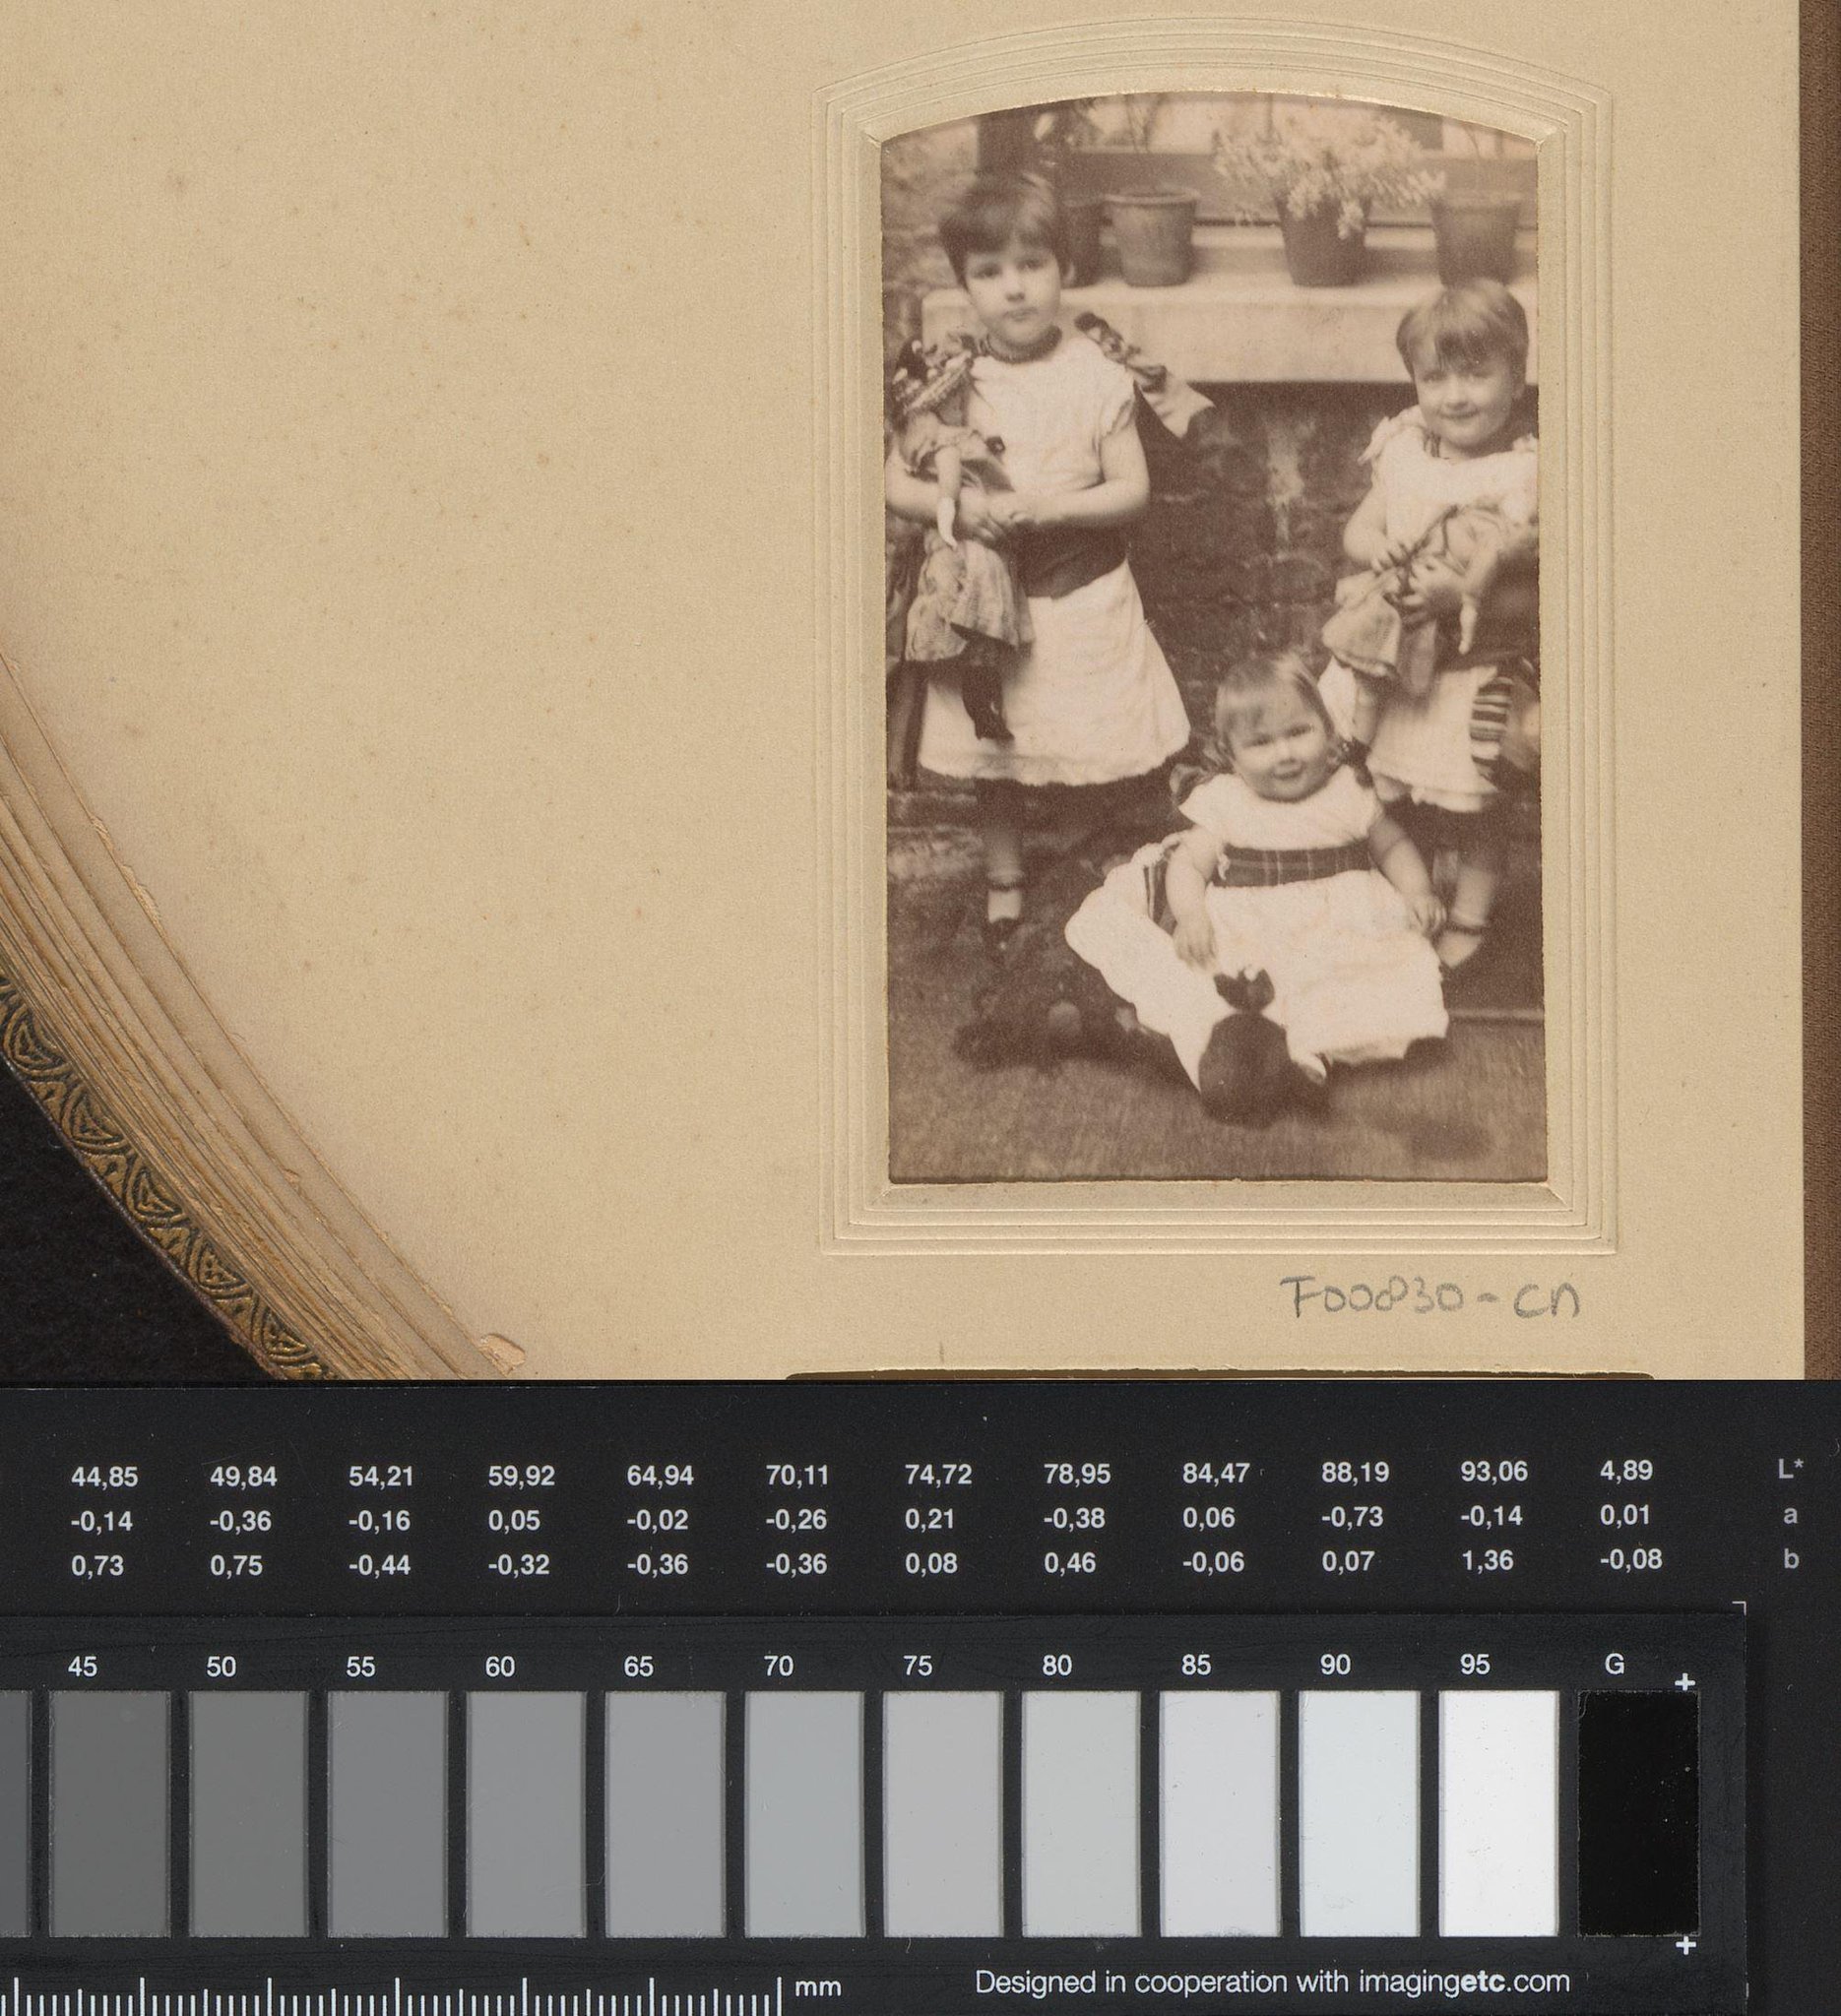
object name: photograph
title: Drie kleuters met poppen bij vensterbank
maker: Anonymous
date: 1870-1900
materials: cardboard, photographic support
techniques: albumen print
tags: child, historical persons, (playing with) dolls